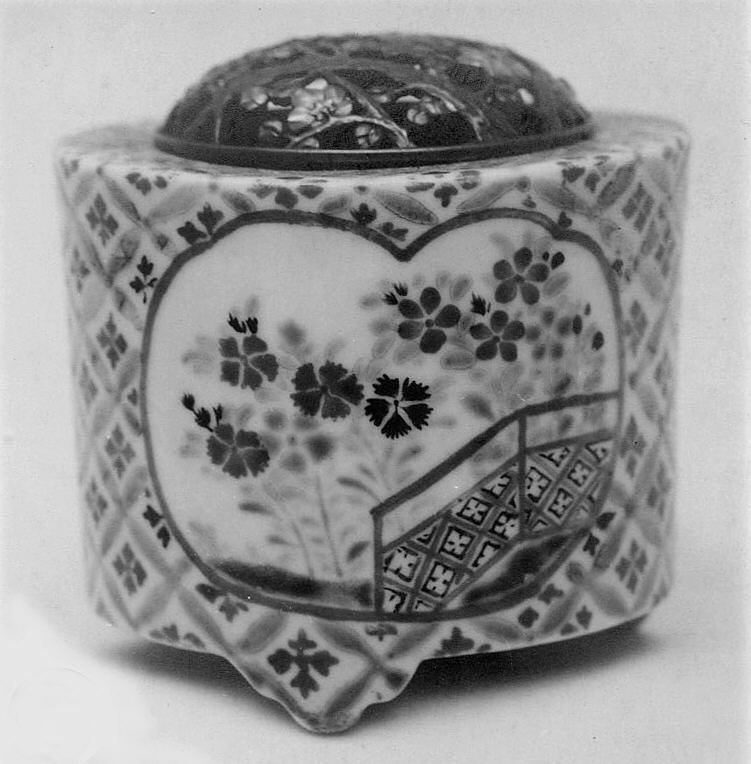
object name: incense burner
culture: japanese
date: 1780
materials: enamel, porcelain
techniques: polychrome